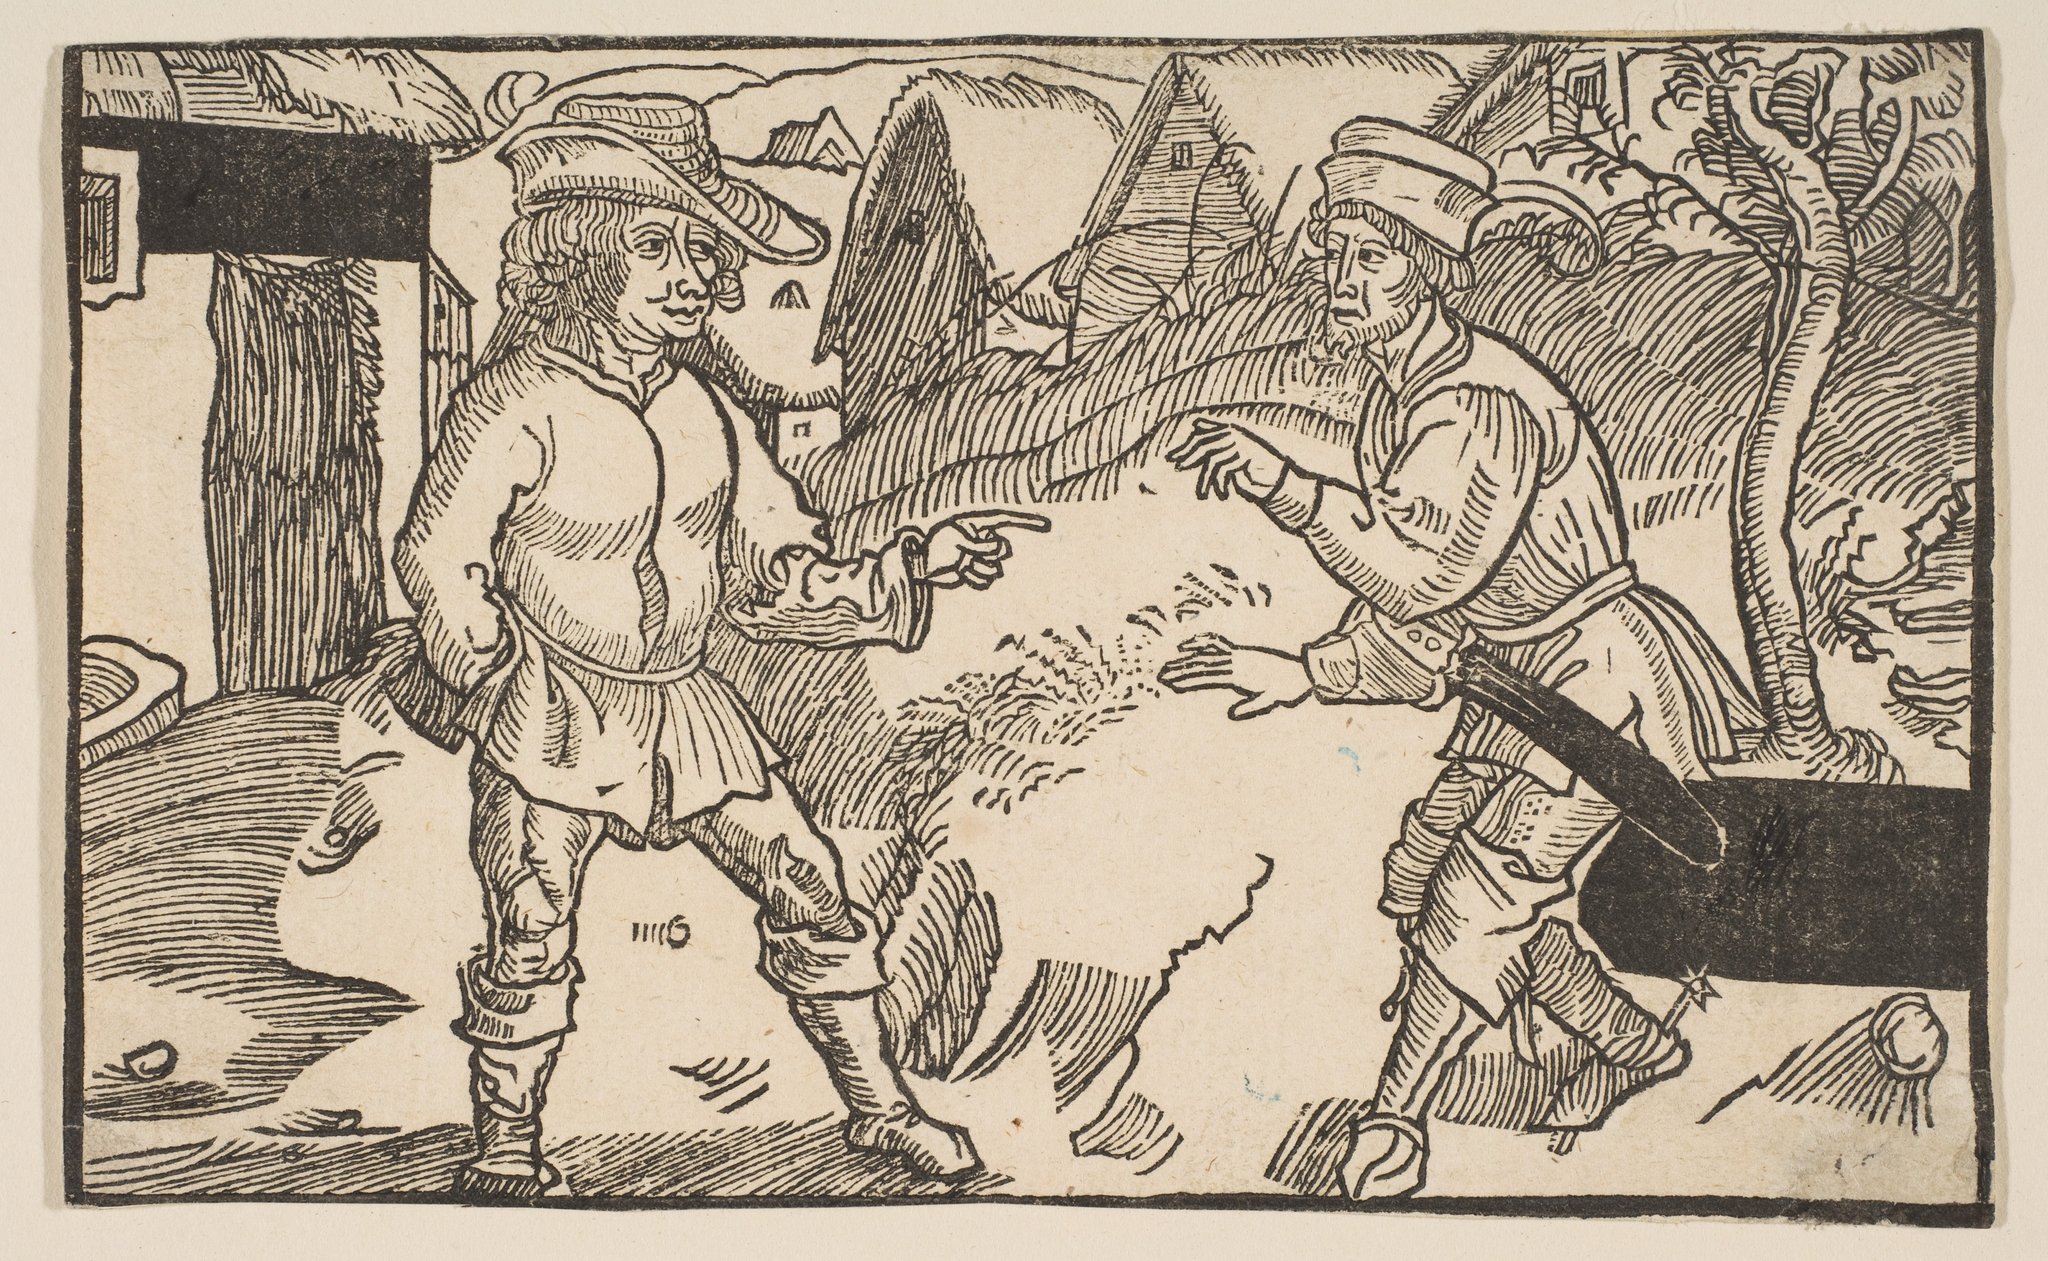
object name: print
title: Heauton Timouroumenos, from "The Comedies of Terence", 19th century reprint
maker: albrecht dürer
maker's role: artist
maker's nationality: german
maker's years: 1471-1528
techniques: woodcut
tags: swords,men